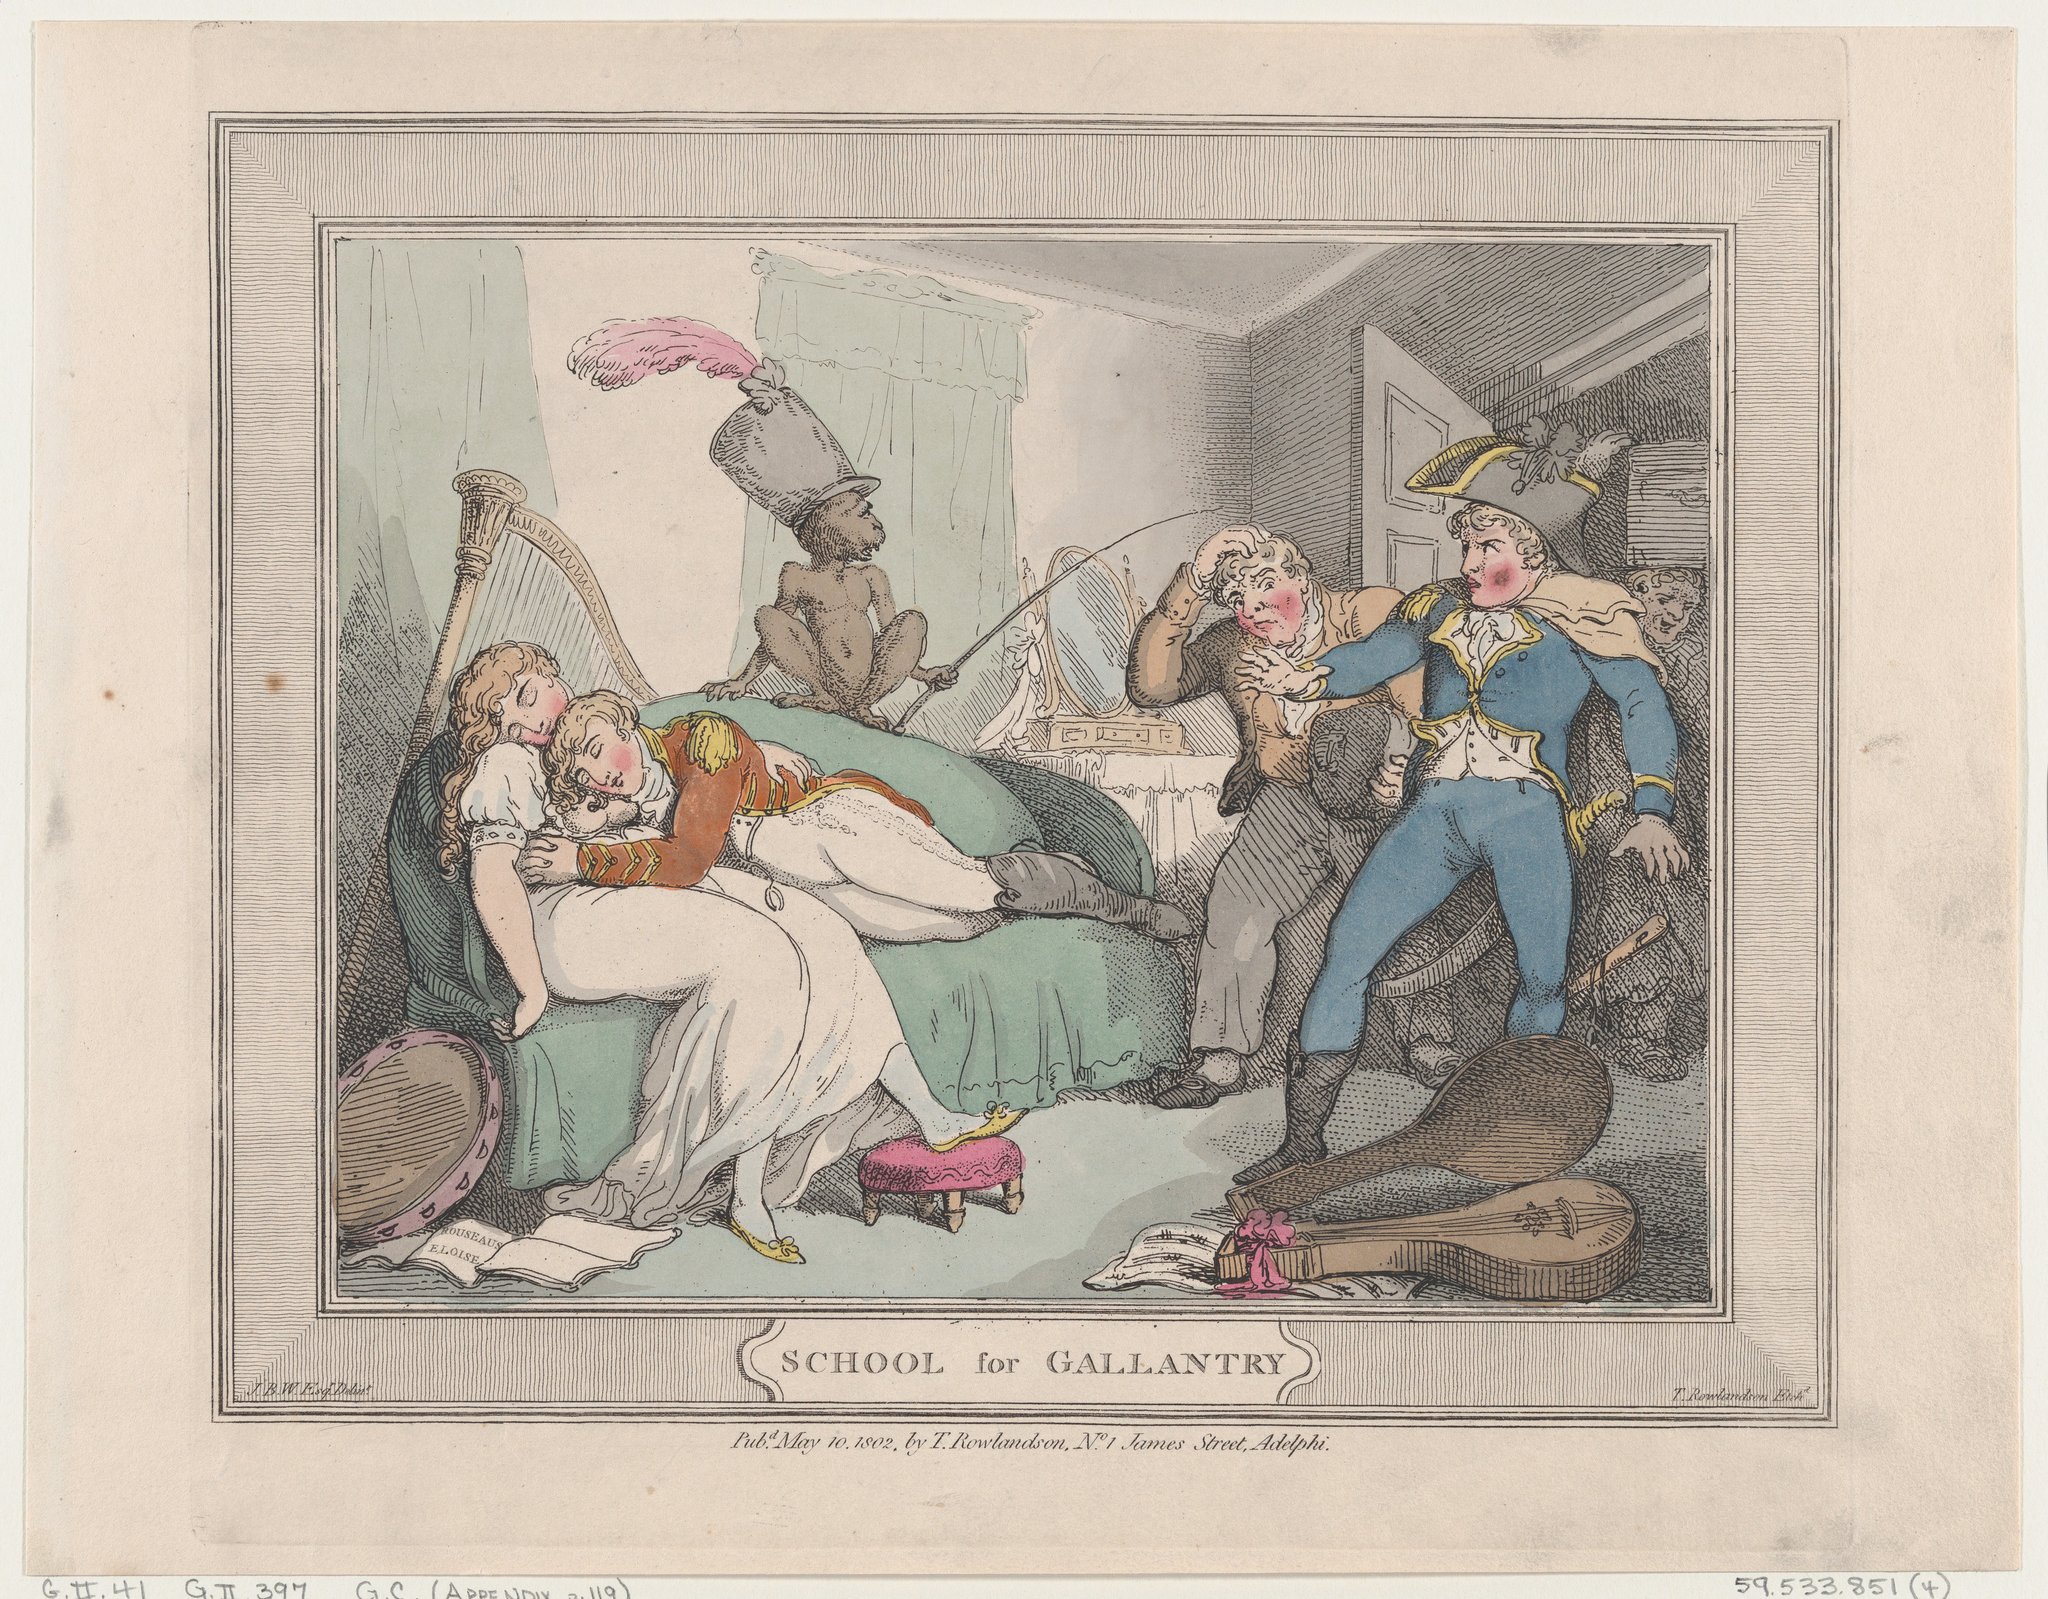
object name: print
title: School for Gallantry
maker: thomas rowlandson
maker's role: artist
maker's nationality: british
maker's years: 1757-1827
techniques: etching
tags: satire,men,women